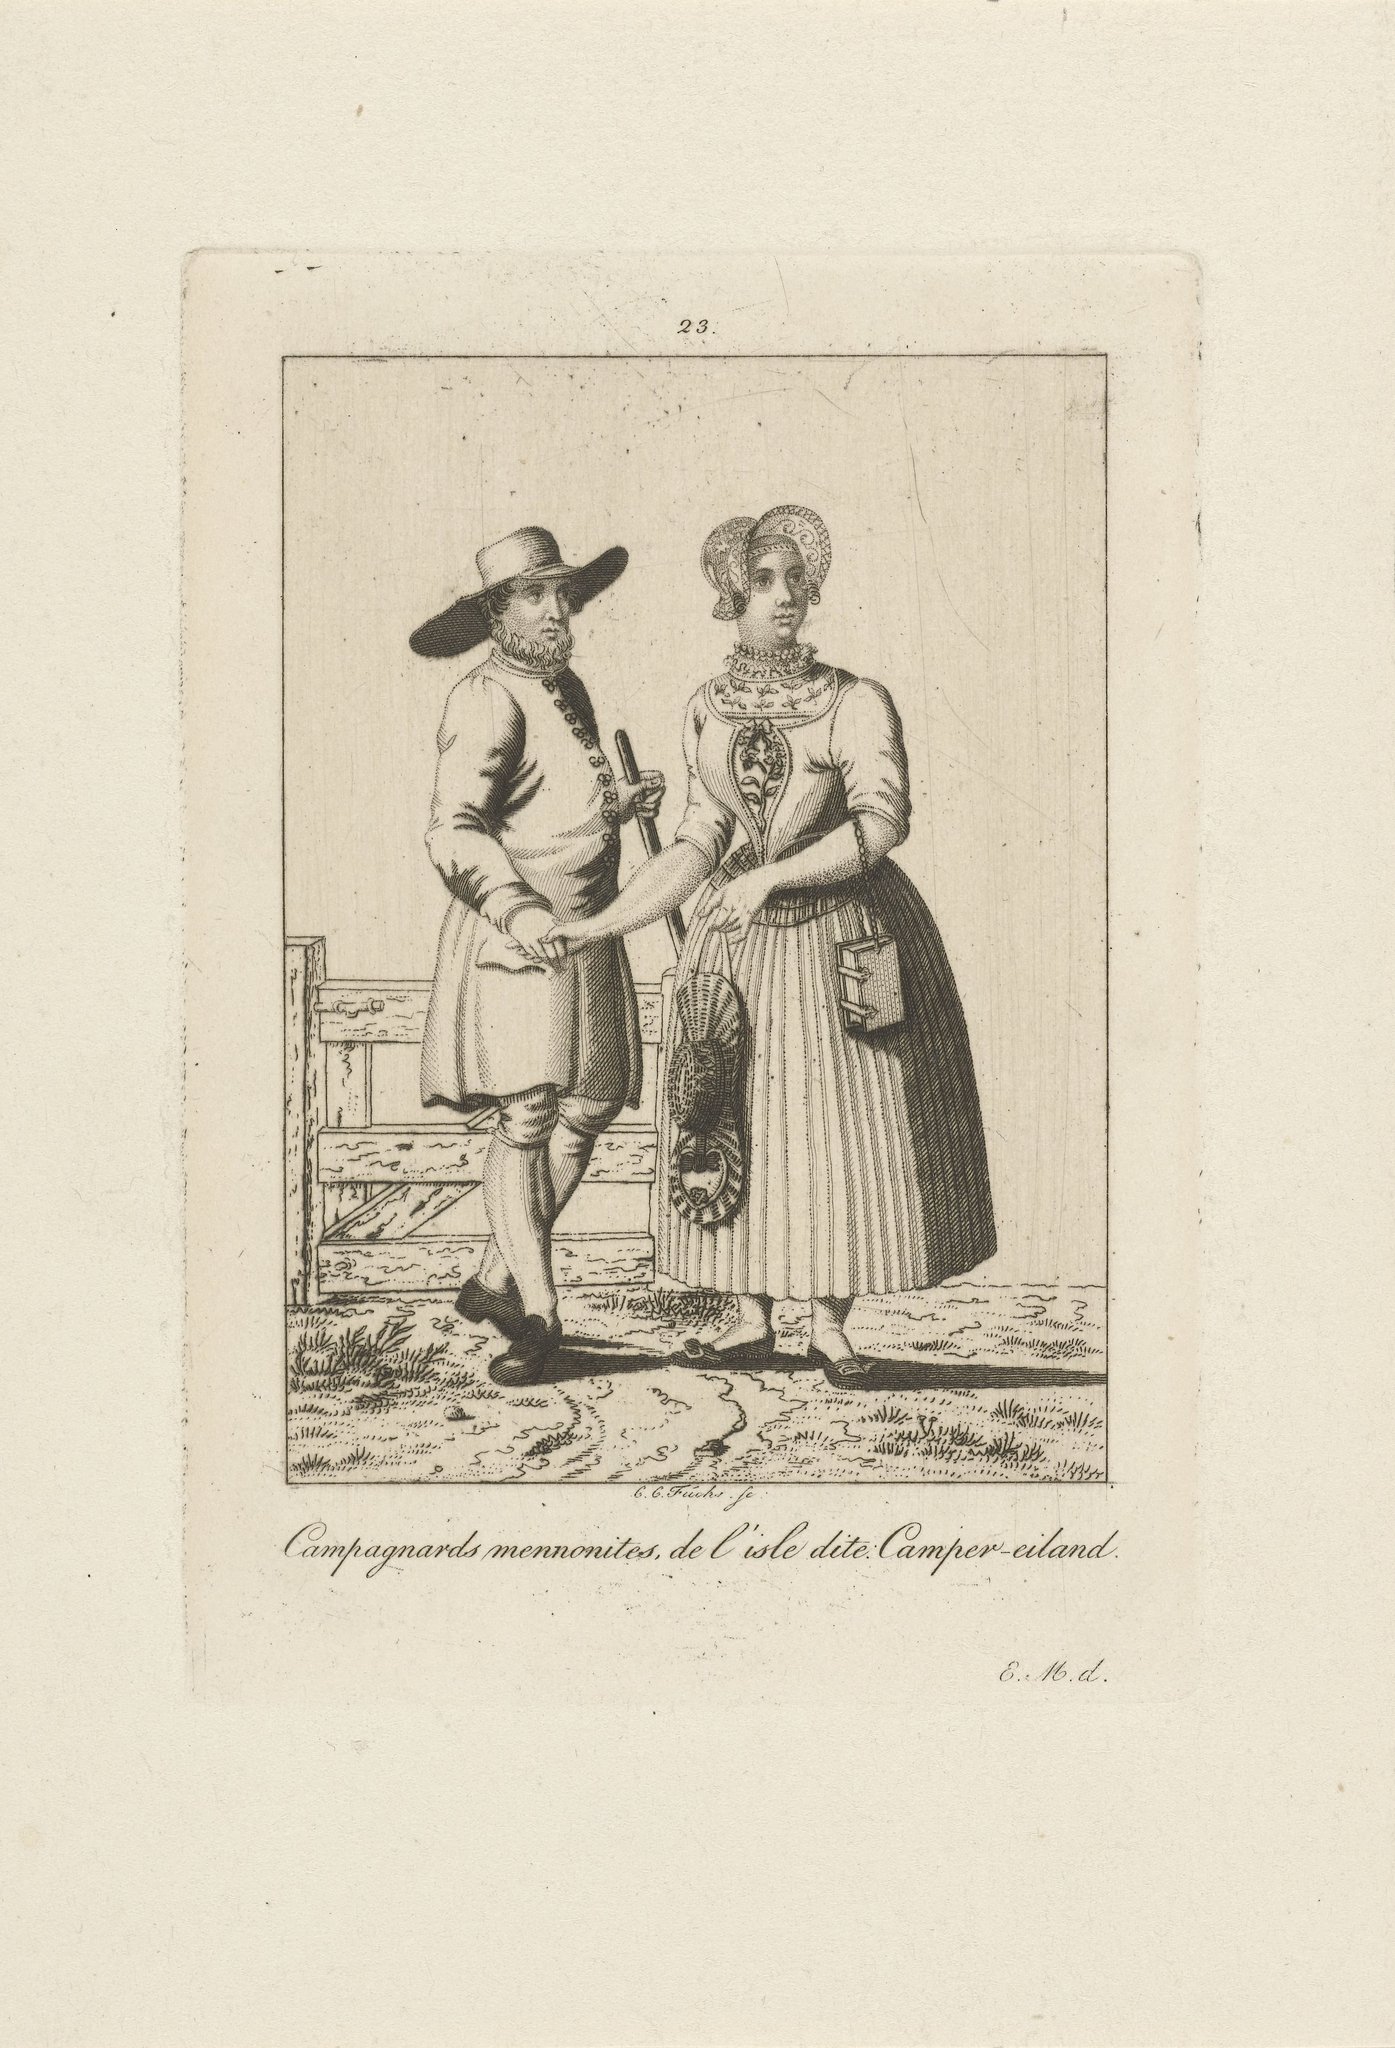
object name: print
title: Man en vrouw in klederdracht uit Kampereiland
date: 1802-1855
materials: paper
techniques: etching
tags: folk costume, regional costume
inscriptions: number: ‘23’, collector's mark: Lugt 2228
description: De originelen bevinden zich in: E. Maaskamp. De kleedingen, zeden & gewoonten in de Nederlanden in den aanvang der 19e eeuw. Amsterdam, 1829.